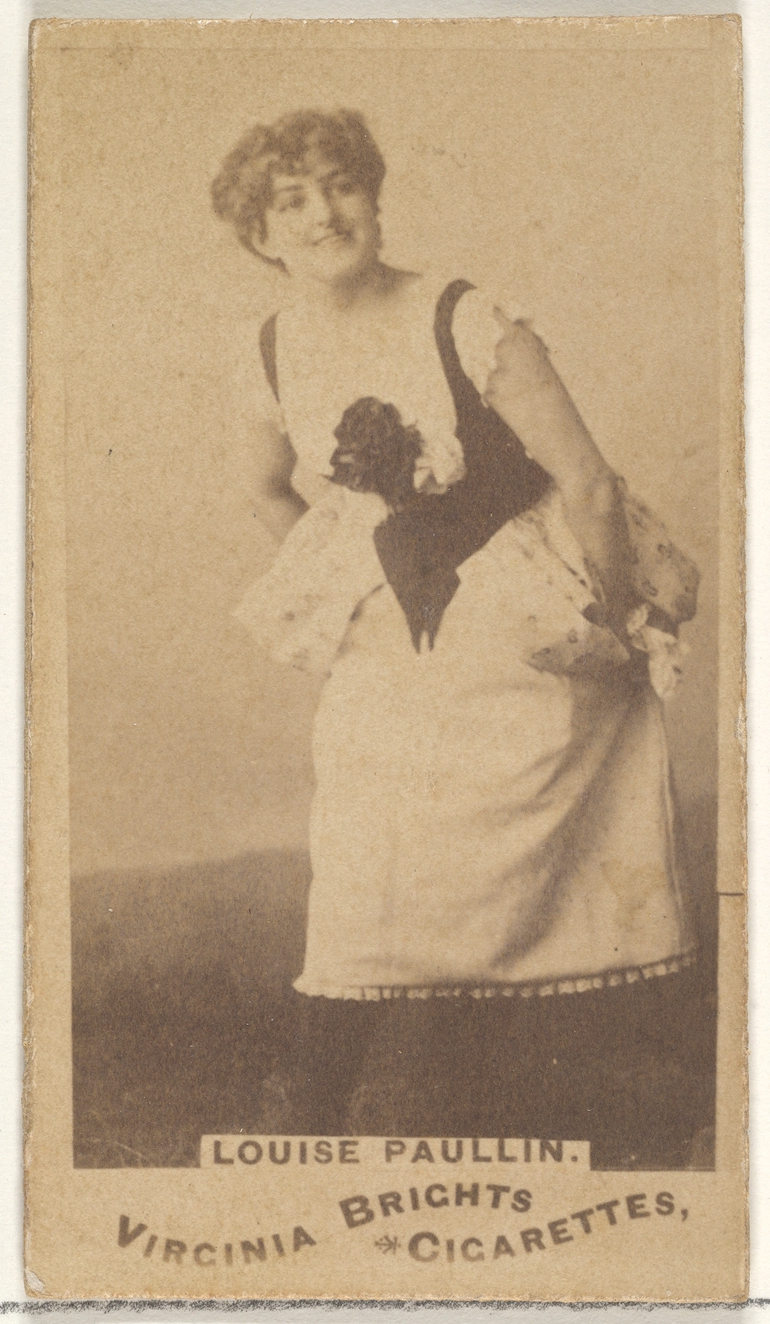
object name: photograph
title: Louise Paullin, from the Actors and Actresses series (N45, Type 1) for Virginia Brights Cigarettes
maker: allen & ginter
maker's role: publisher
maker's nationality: american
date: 1888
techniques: albumen silver print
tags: portraits,women,actresses